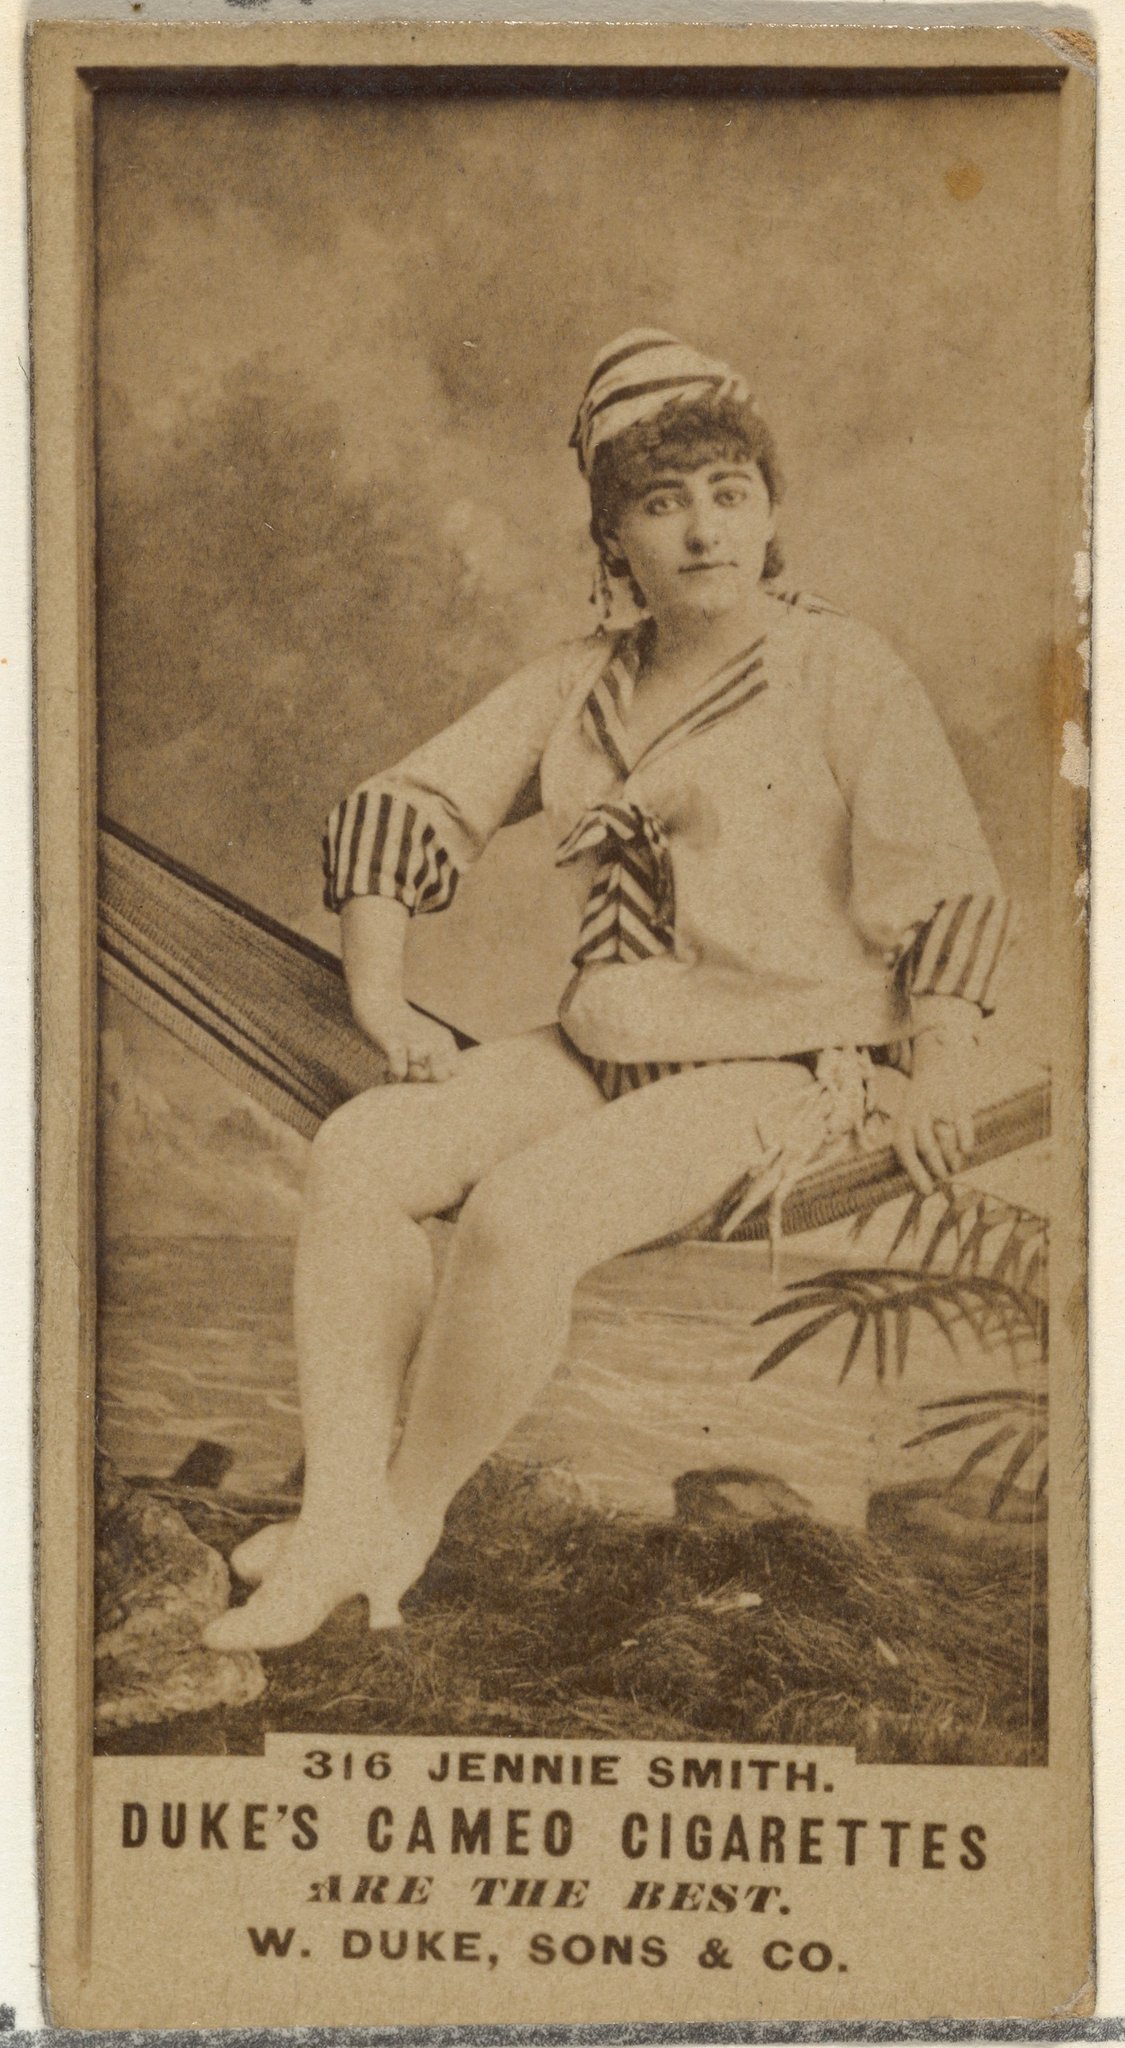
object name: photograph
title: Card Number 316, Jennie Smith, from the Actors and Actresses series (N145-5) issued by Duke Sons & Co. to promote Cameo Cigarettes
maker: w. duke, sons & co.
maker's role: publisher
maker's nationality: american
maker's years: 1870-1920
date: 1880-1889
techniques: albumen silver print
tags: portraits,women,actresses